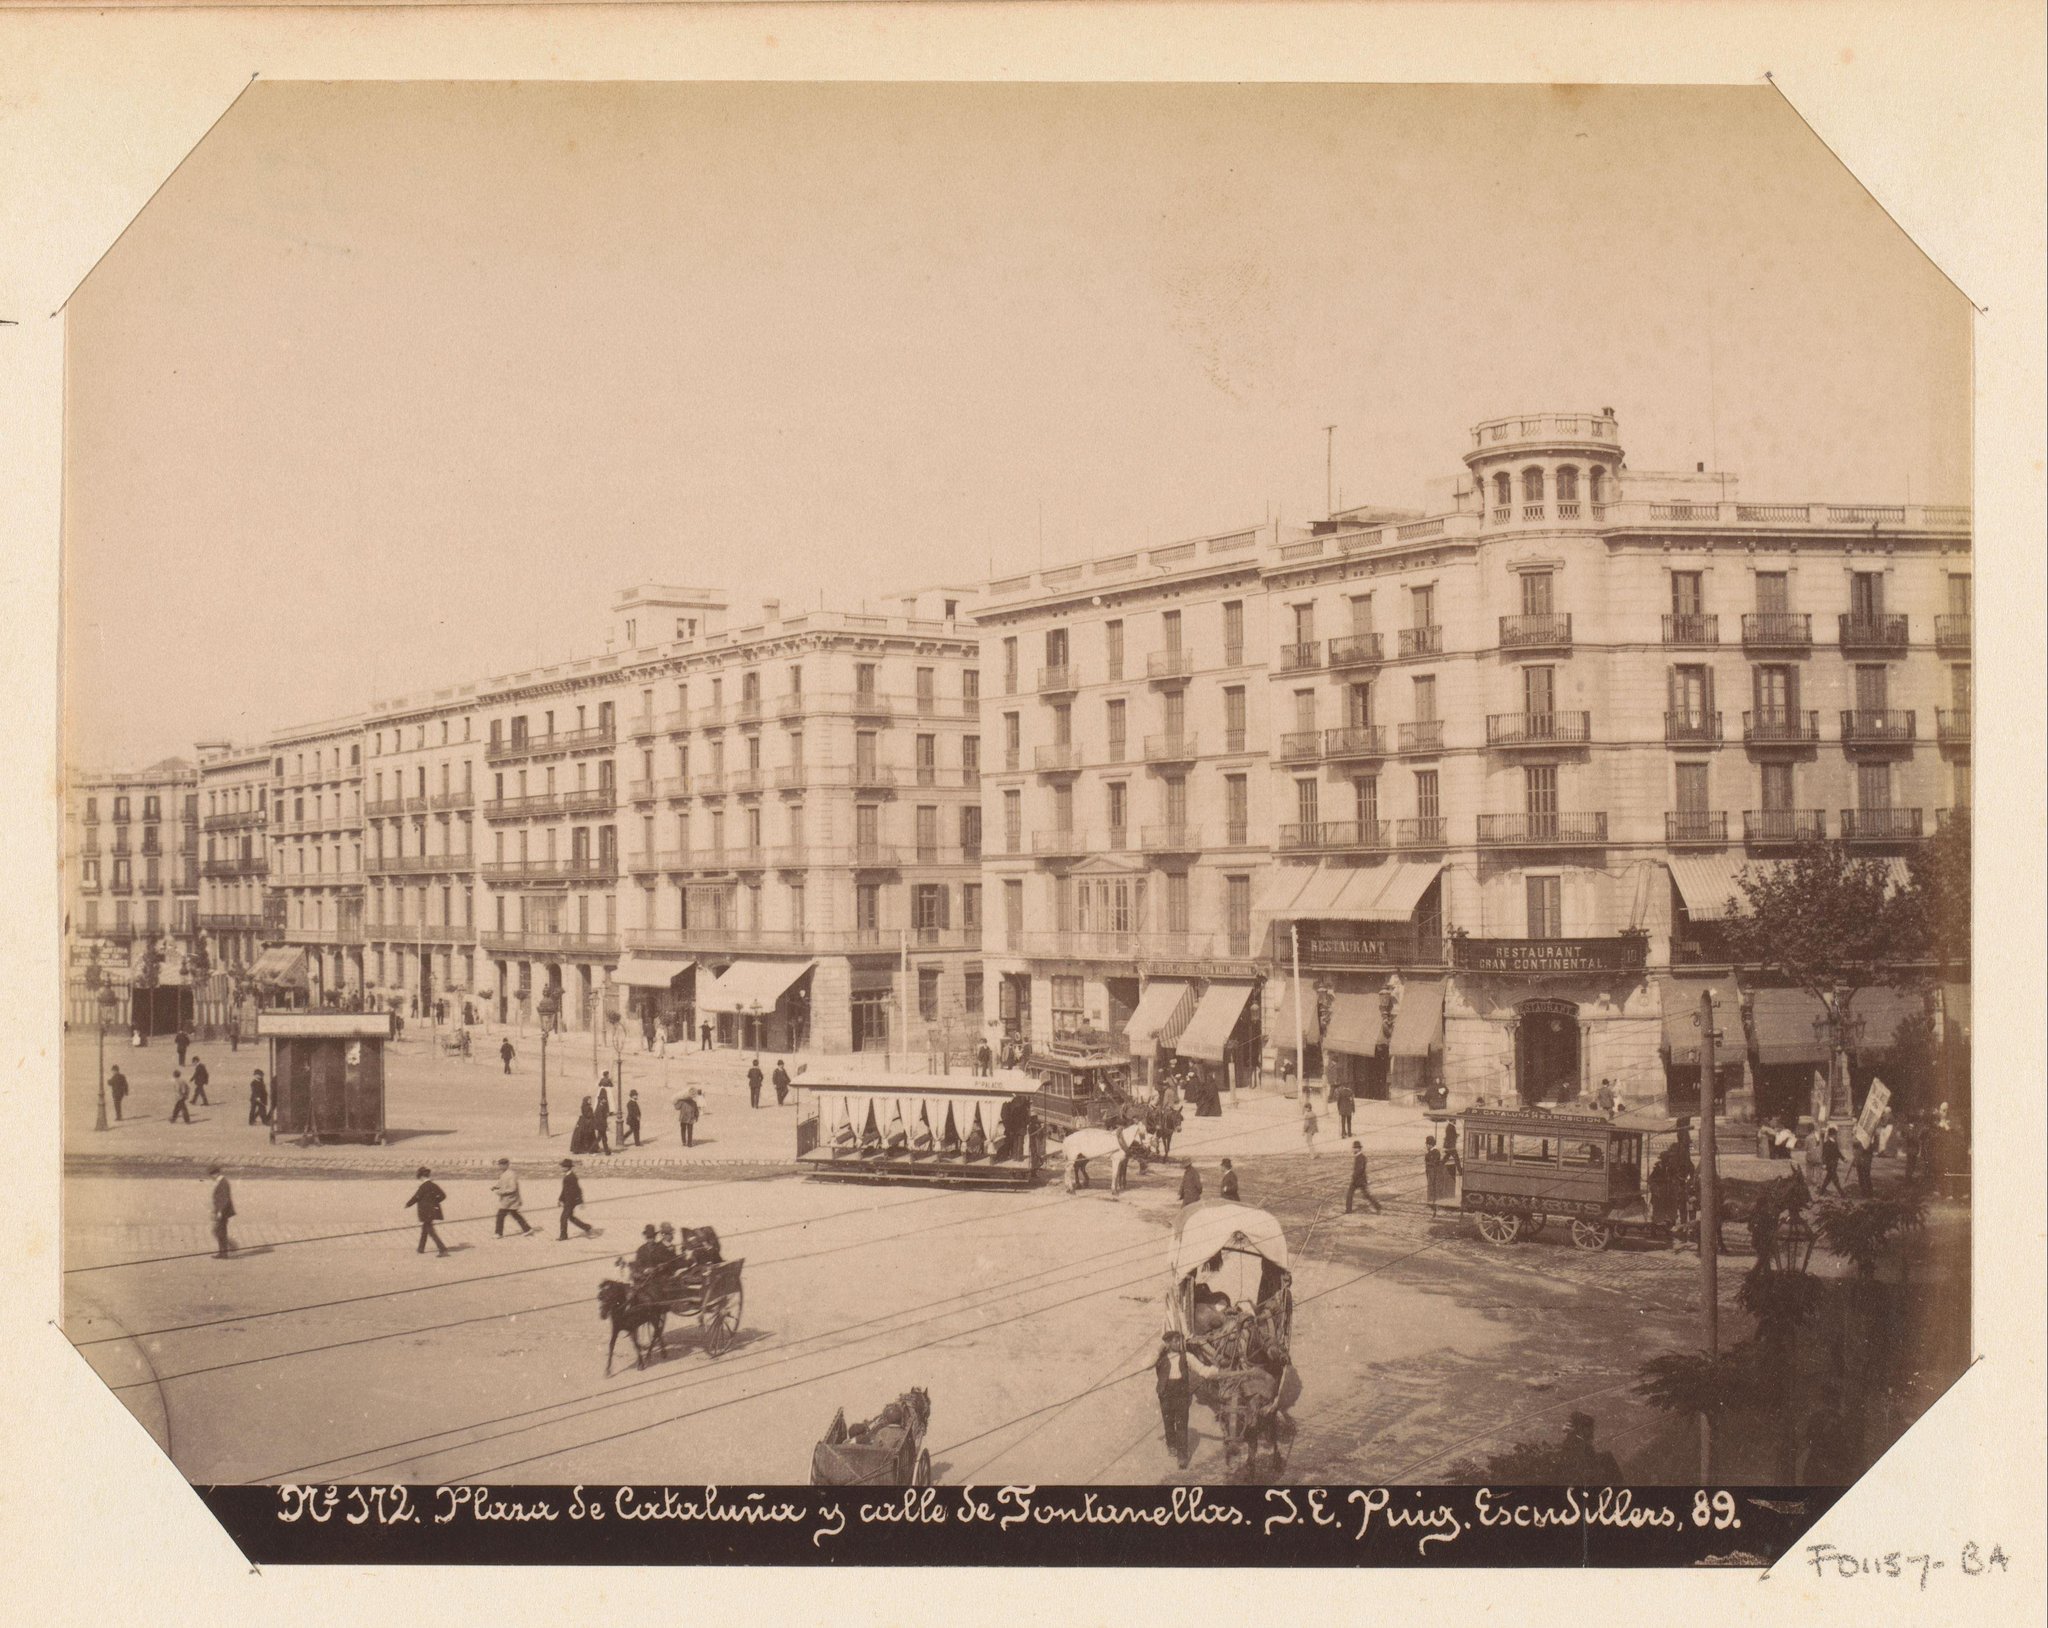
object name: photograph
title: Plaza de Cataluña y calle de Fontanellas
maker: j.e. puig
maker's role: fotograaf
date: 1885-1892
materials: photographic support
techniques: albumen print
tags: square, place, circus, etc., street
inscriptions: annotation: ‘Barcelona - Plaza de Cataluña’, number: ‘172’